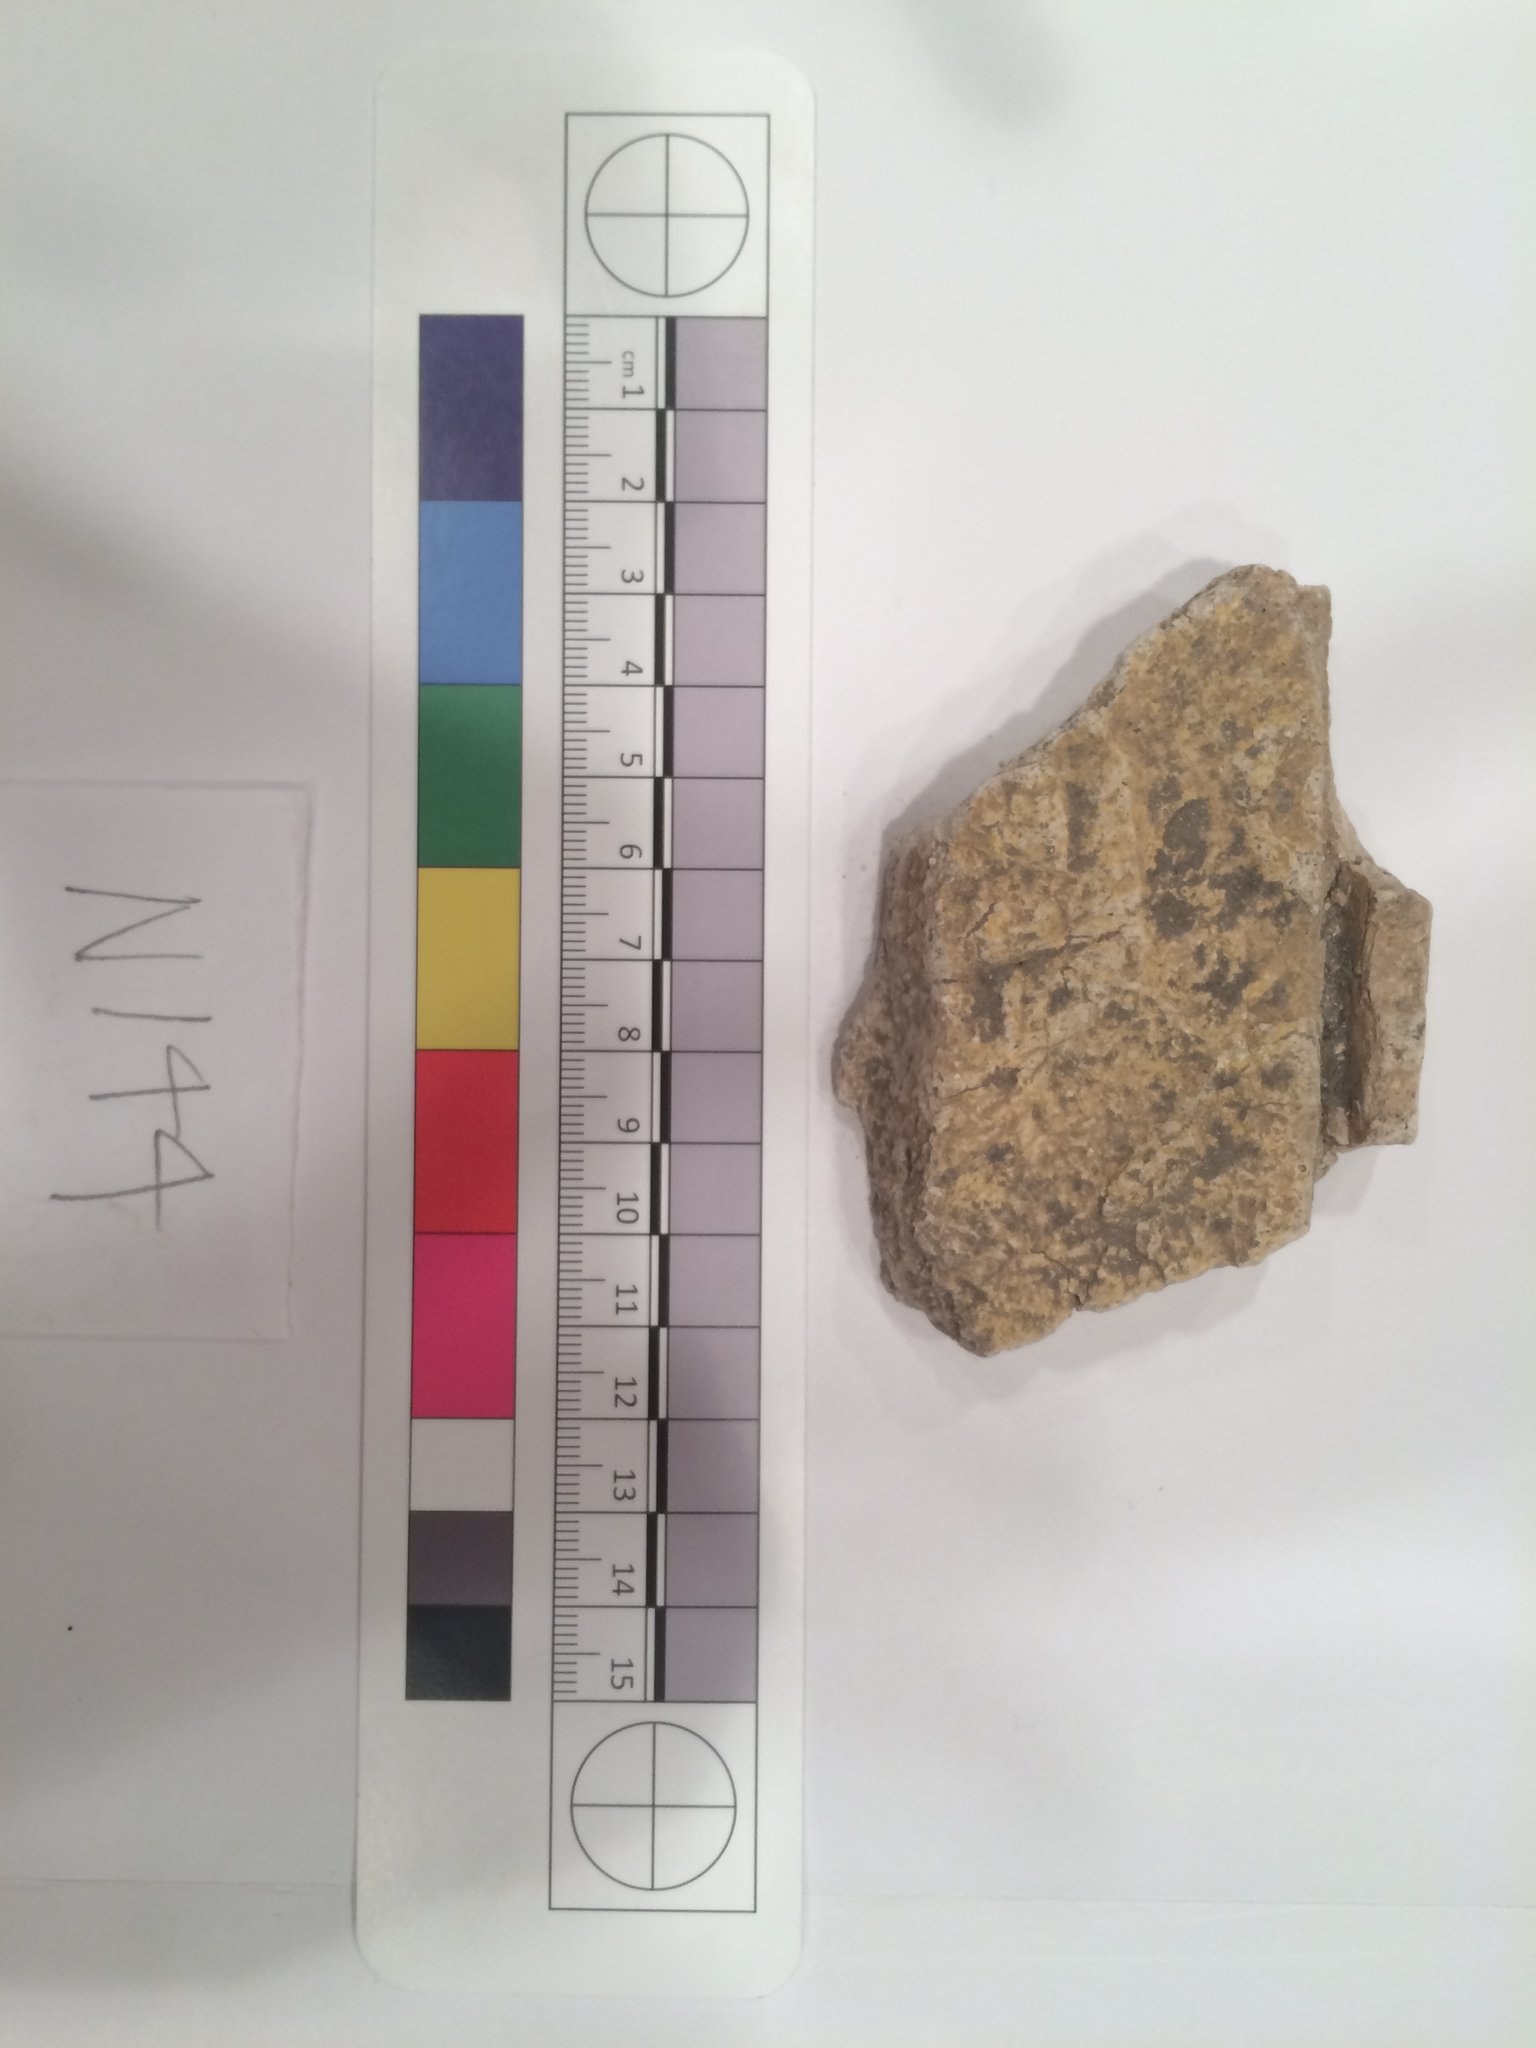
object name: fragment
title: Stucco Fragment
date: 701-1200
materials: plaster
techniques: carving, painting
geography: iran